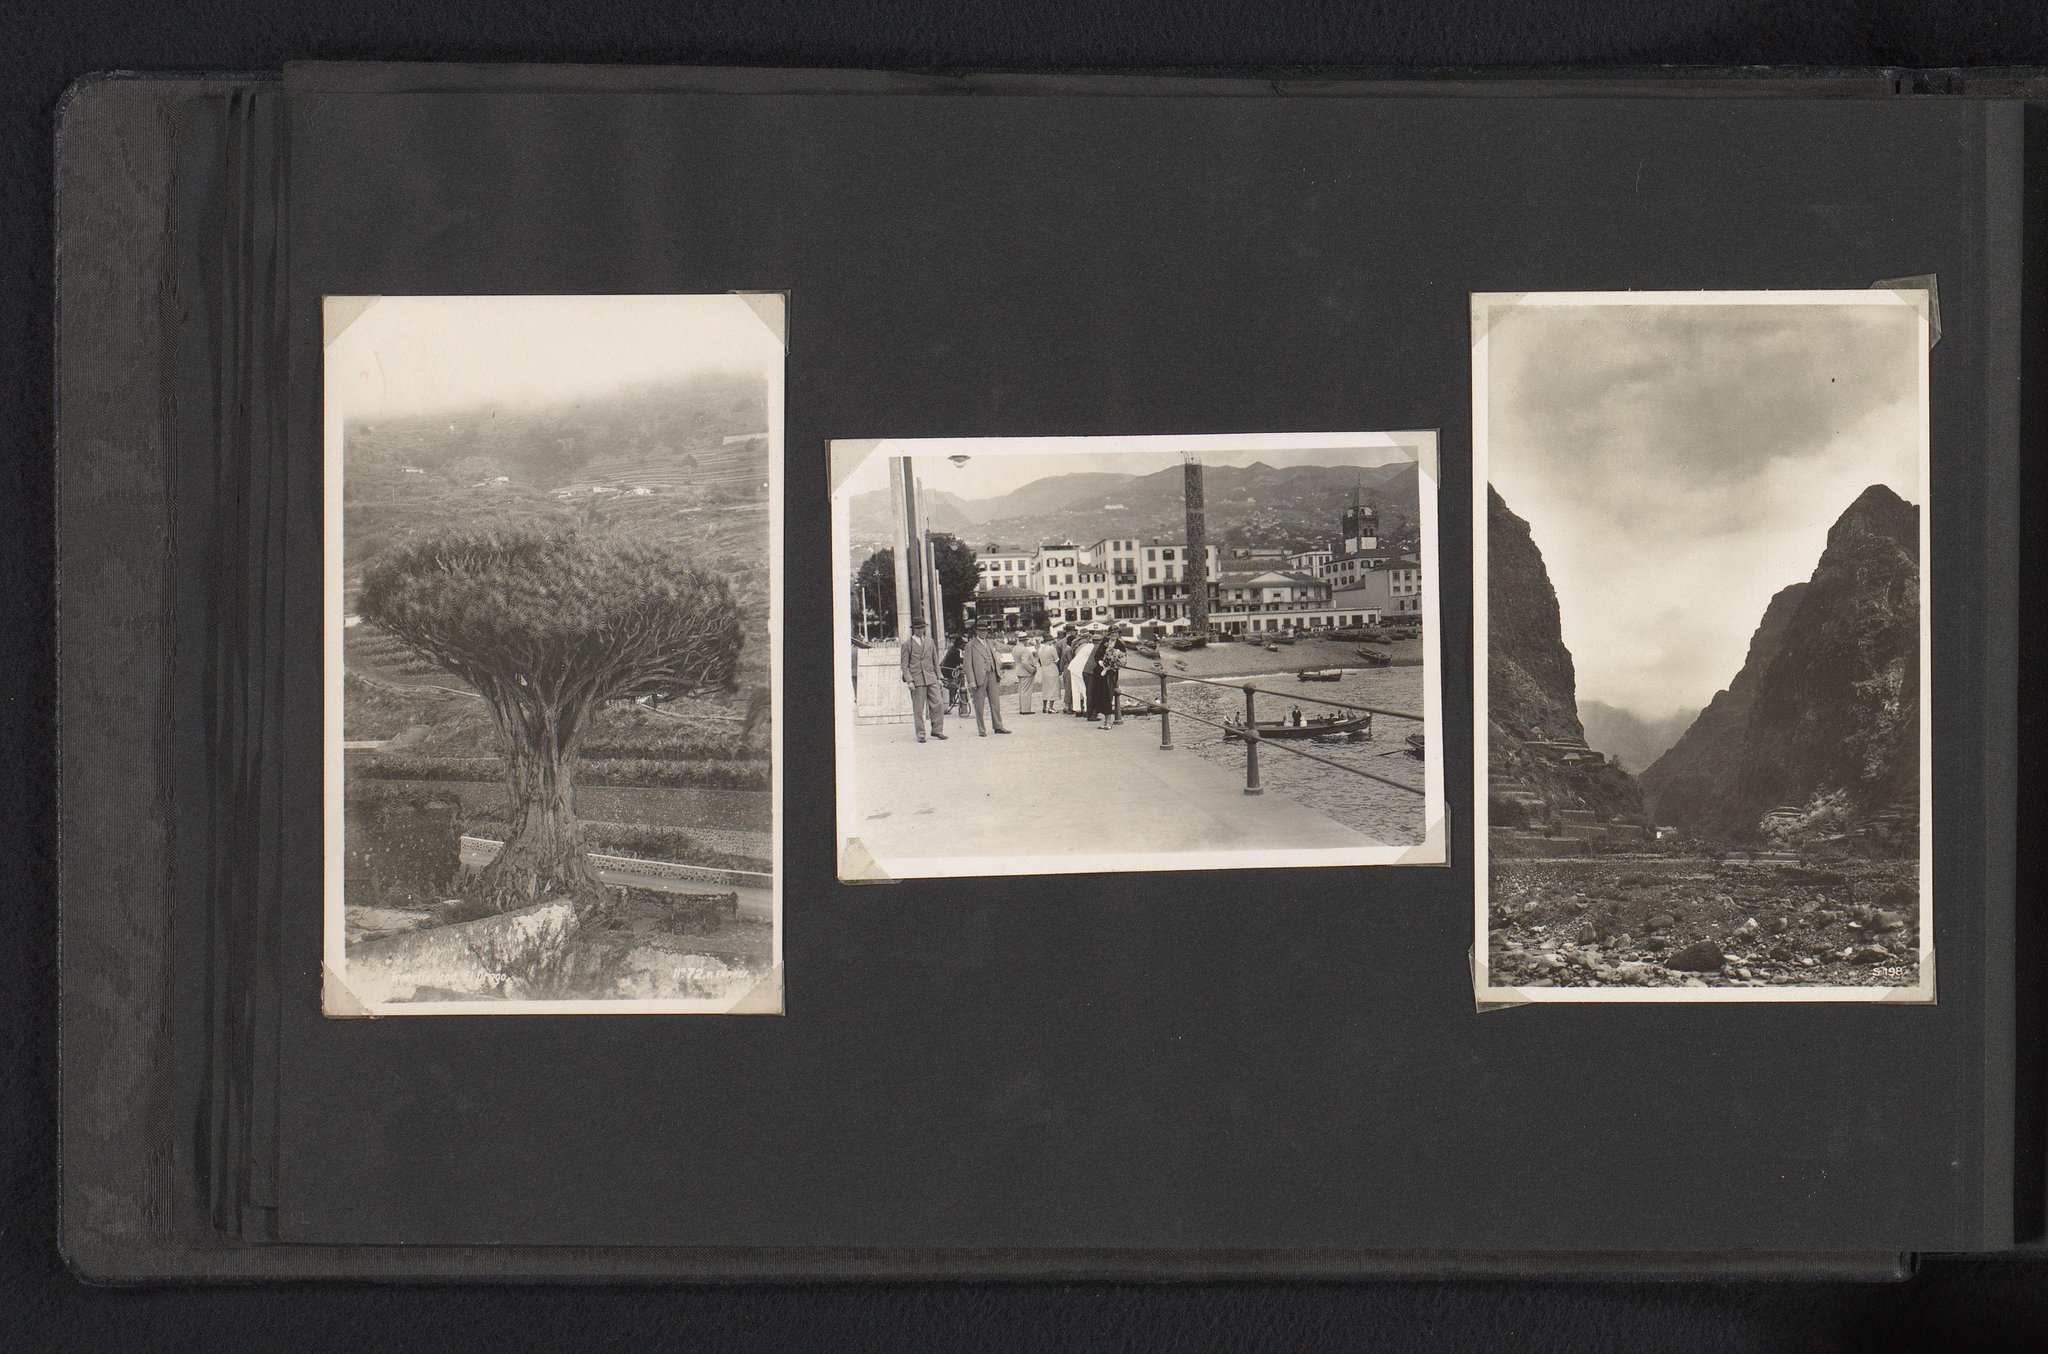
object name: photograph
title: Drie foto's, waarvan twee prentbriefkaarten, van Madeira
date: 1933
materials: paper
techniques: gelatin silver print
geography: madeira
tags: trees, pier, quay, wharf, mountains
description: Deze foto's maken deel uit van een album.